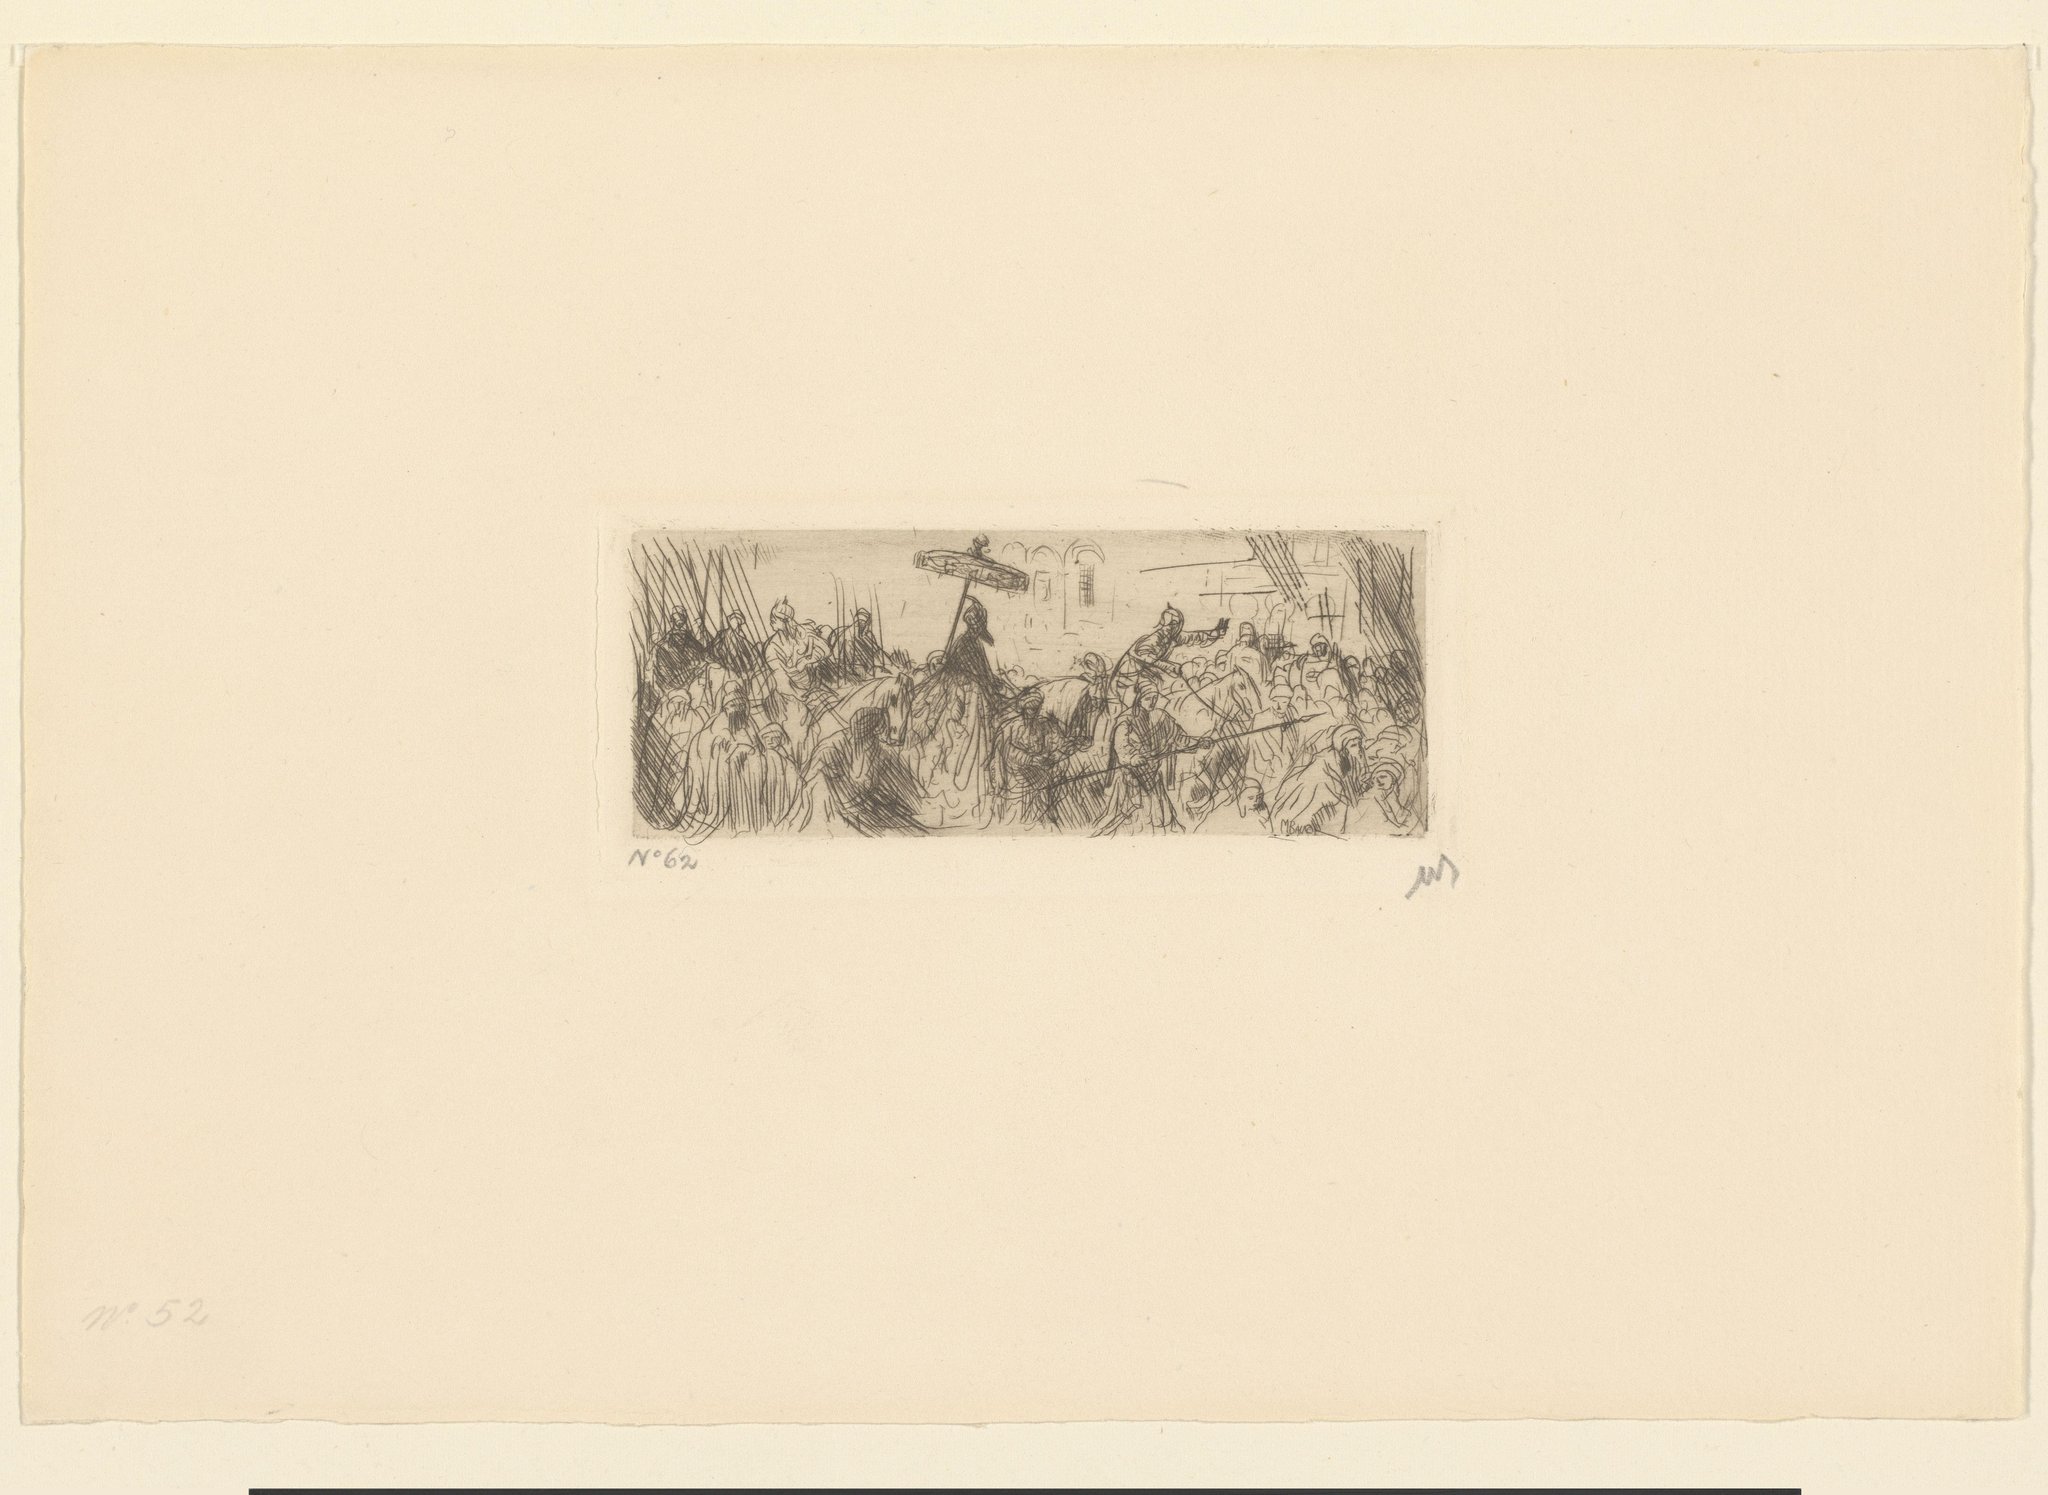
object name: print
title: Grootvizier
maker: marius bauer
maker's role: draughtsman, print maker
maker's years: 1867-1932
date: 1900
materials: paper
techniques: etching, intaglio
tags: prime minister, riding a horse, ass, or mule; rider, horseman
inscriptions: collector's mark: Lugt 2228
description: Een grootvizier zittend op een paard. Er wordt een parasol boven zijn hoofd gehouden. Hij wordt omringd door bewakers, waarvan sommigen ook te paard.